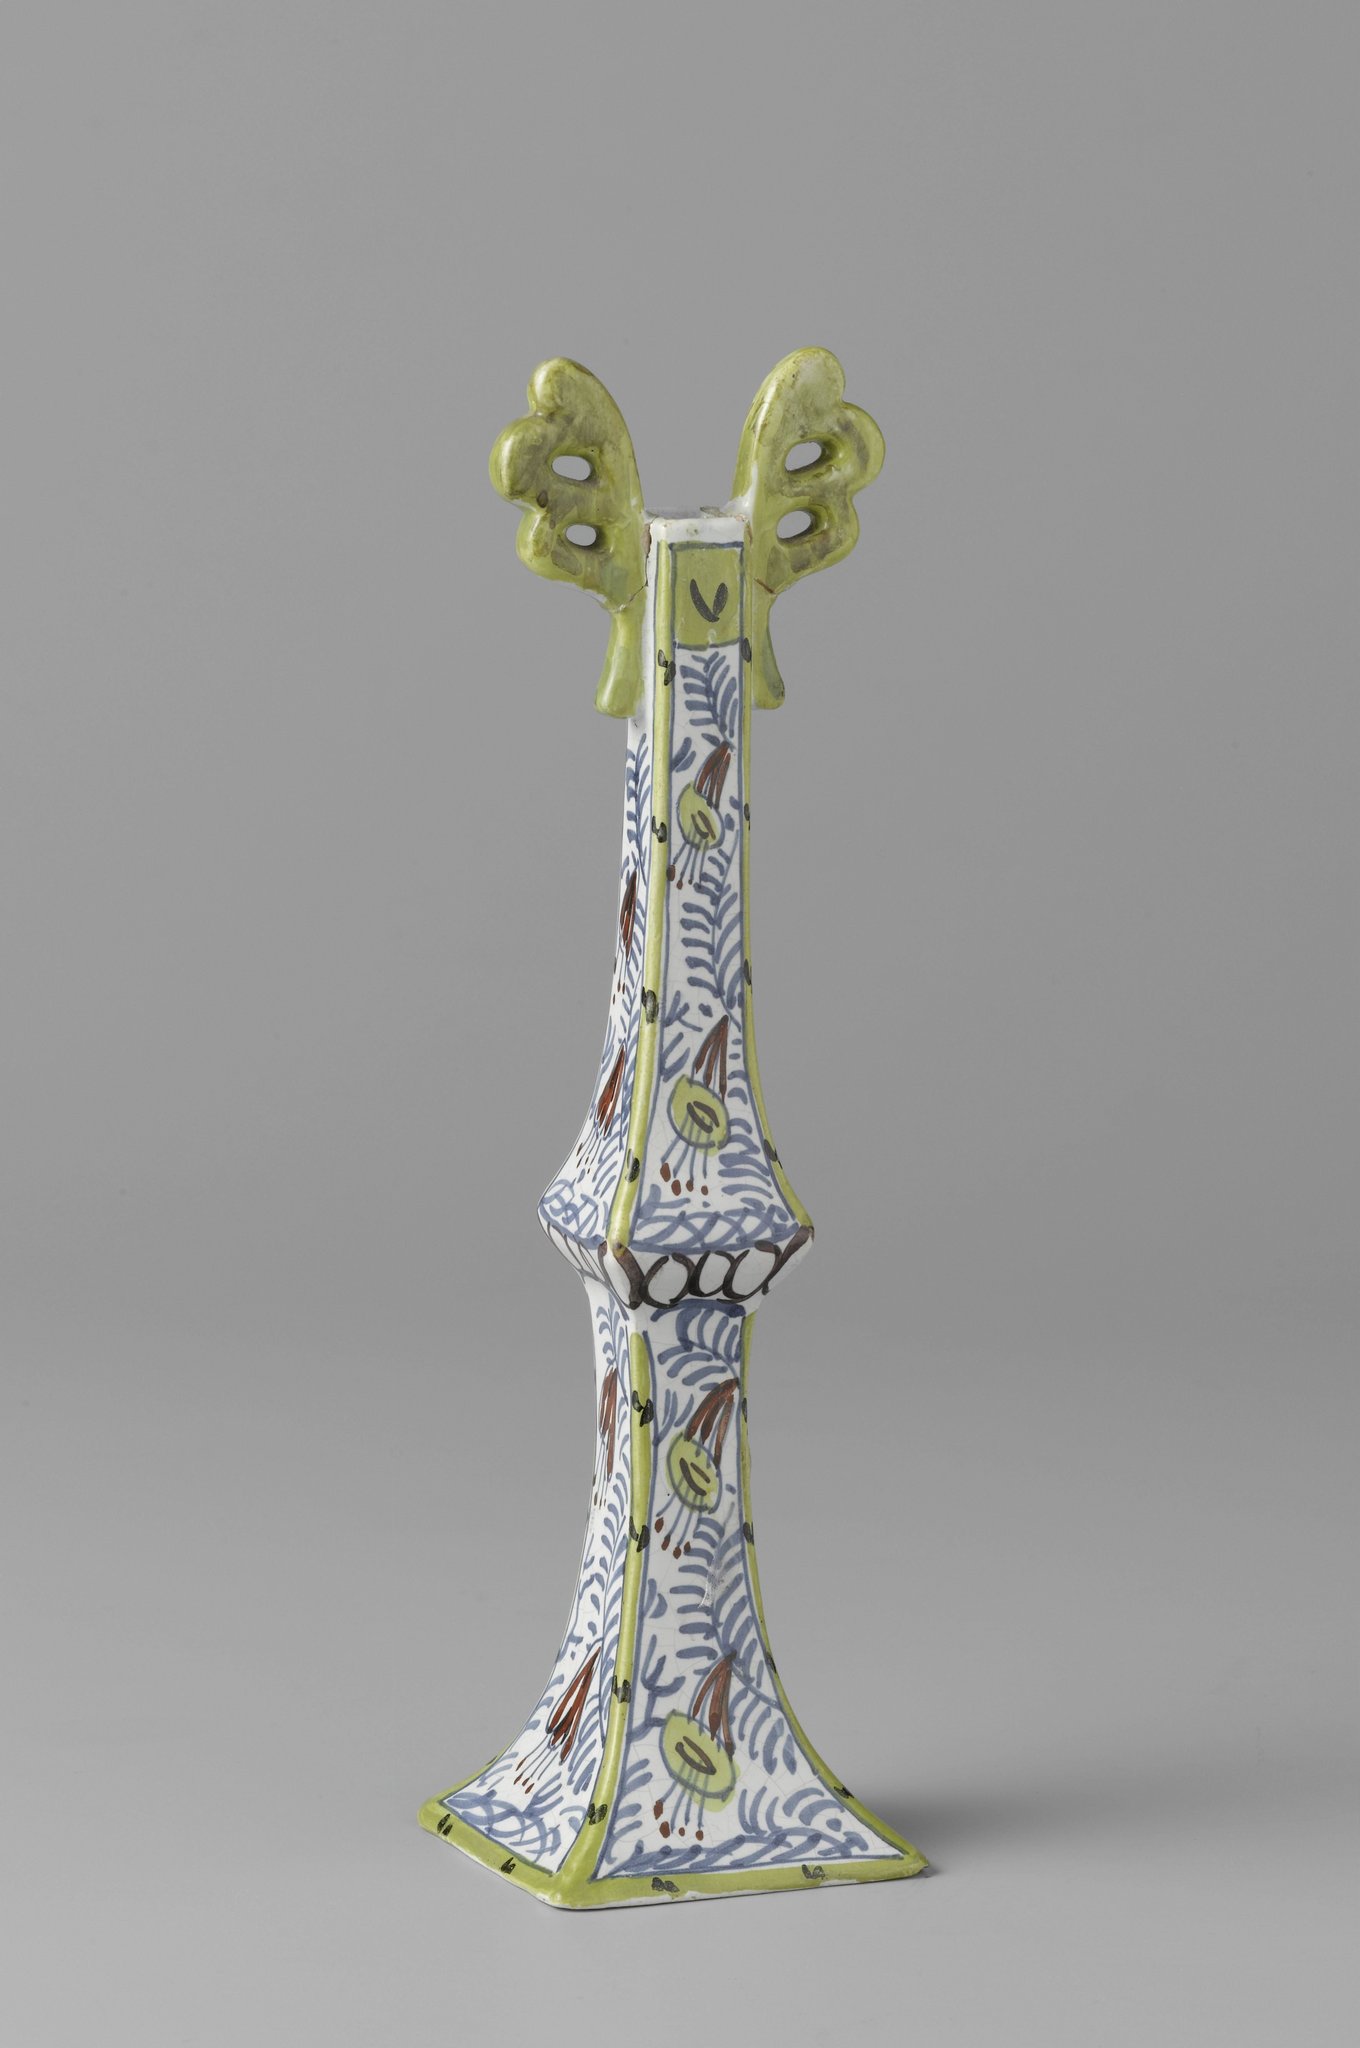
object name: vase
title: Vaas met gestileerde bloem- en bladversiering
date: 1880-1920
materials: earthenware, glaze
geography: delft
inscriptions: mark: ‘fles // F // Delft // ... // 187’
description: Vaas van aardewerk, vierkante voet en zich verjongende stam met vierkante nodus. Bovenste deel van de stam wordt nog smaller en wordt aan weerszijden bekroond door twee opengewerkte ornamenten. Beschilderd met gestileerd bloem- en bladwerk in de kleuren blauw, groen en rood.